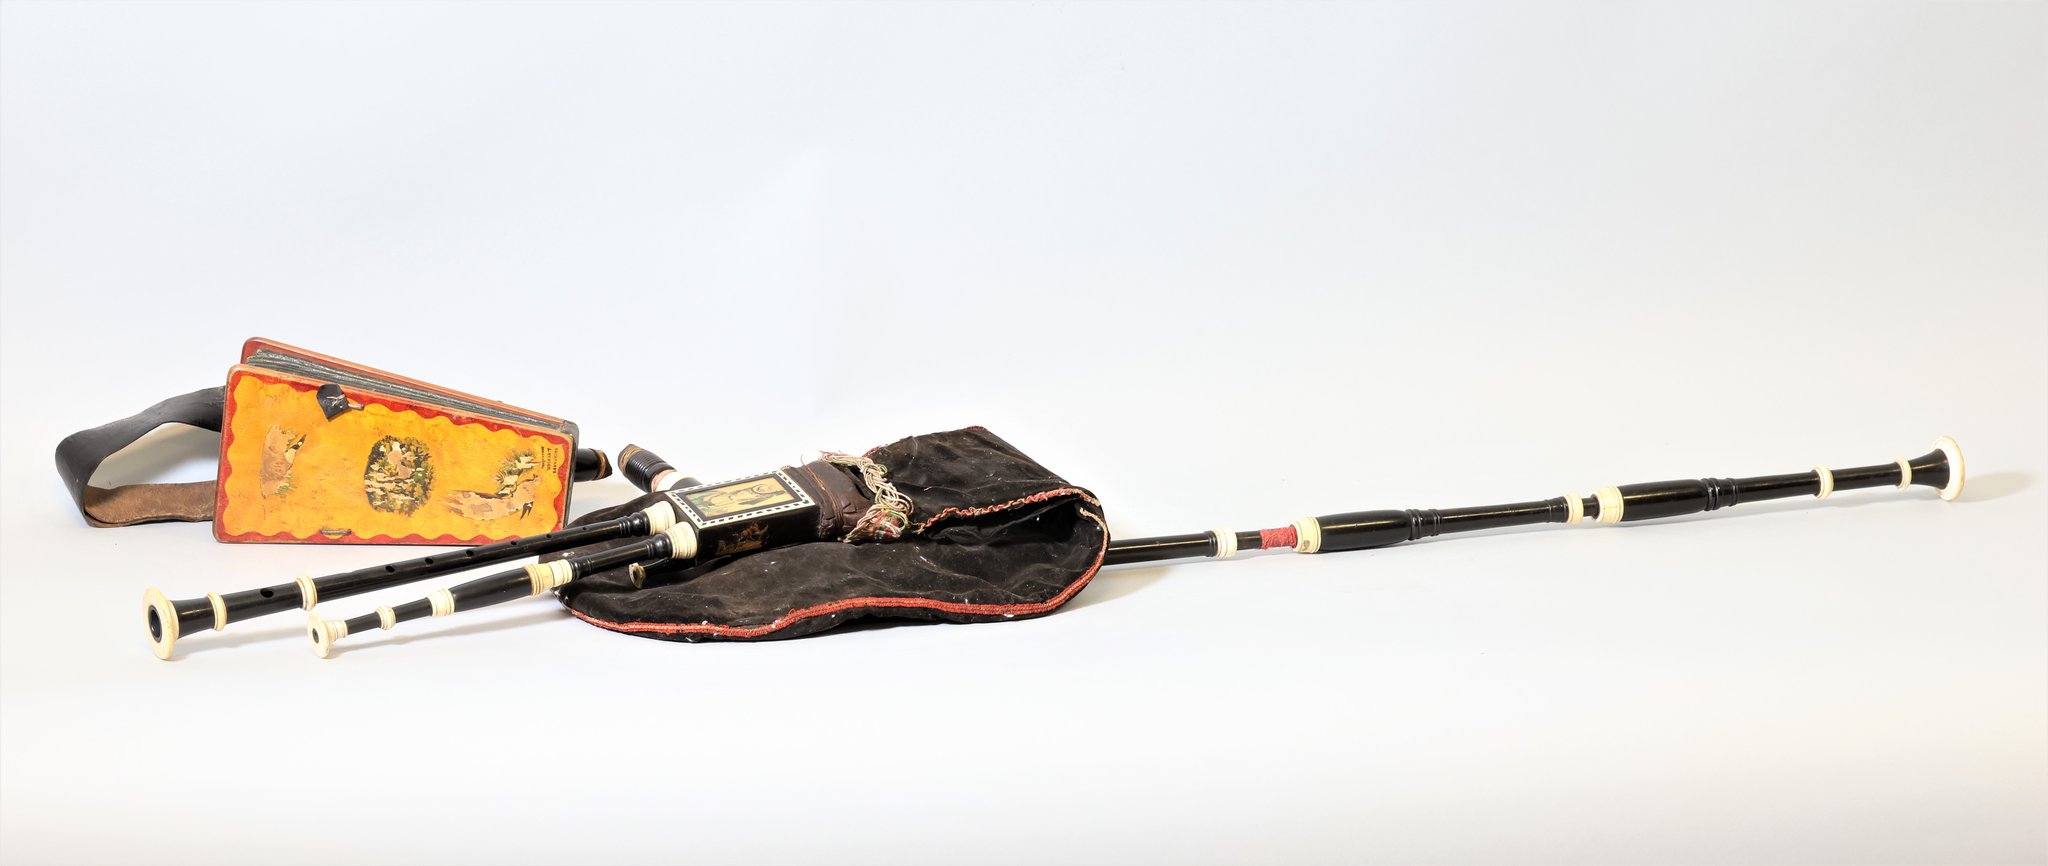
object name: cornemuse béchonnet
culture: french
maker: joseph bechonnet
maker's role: maker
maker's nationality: french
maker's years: 1820-1900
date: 1874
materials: ivory, leather, velvet, wood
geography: france